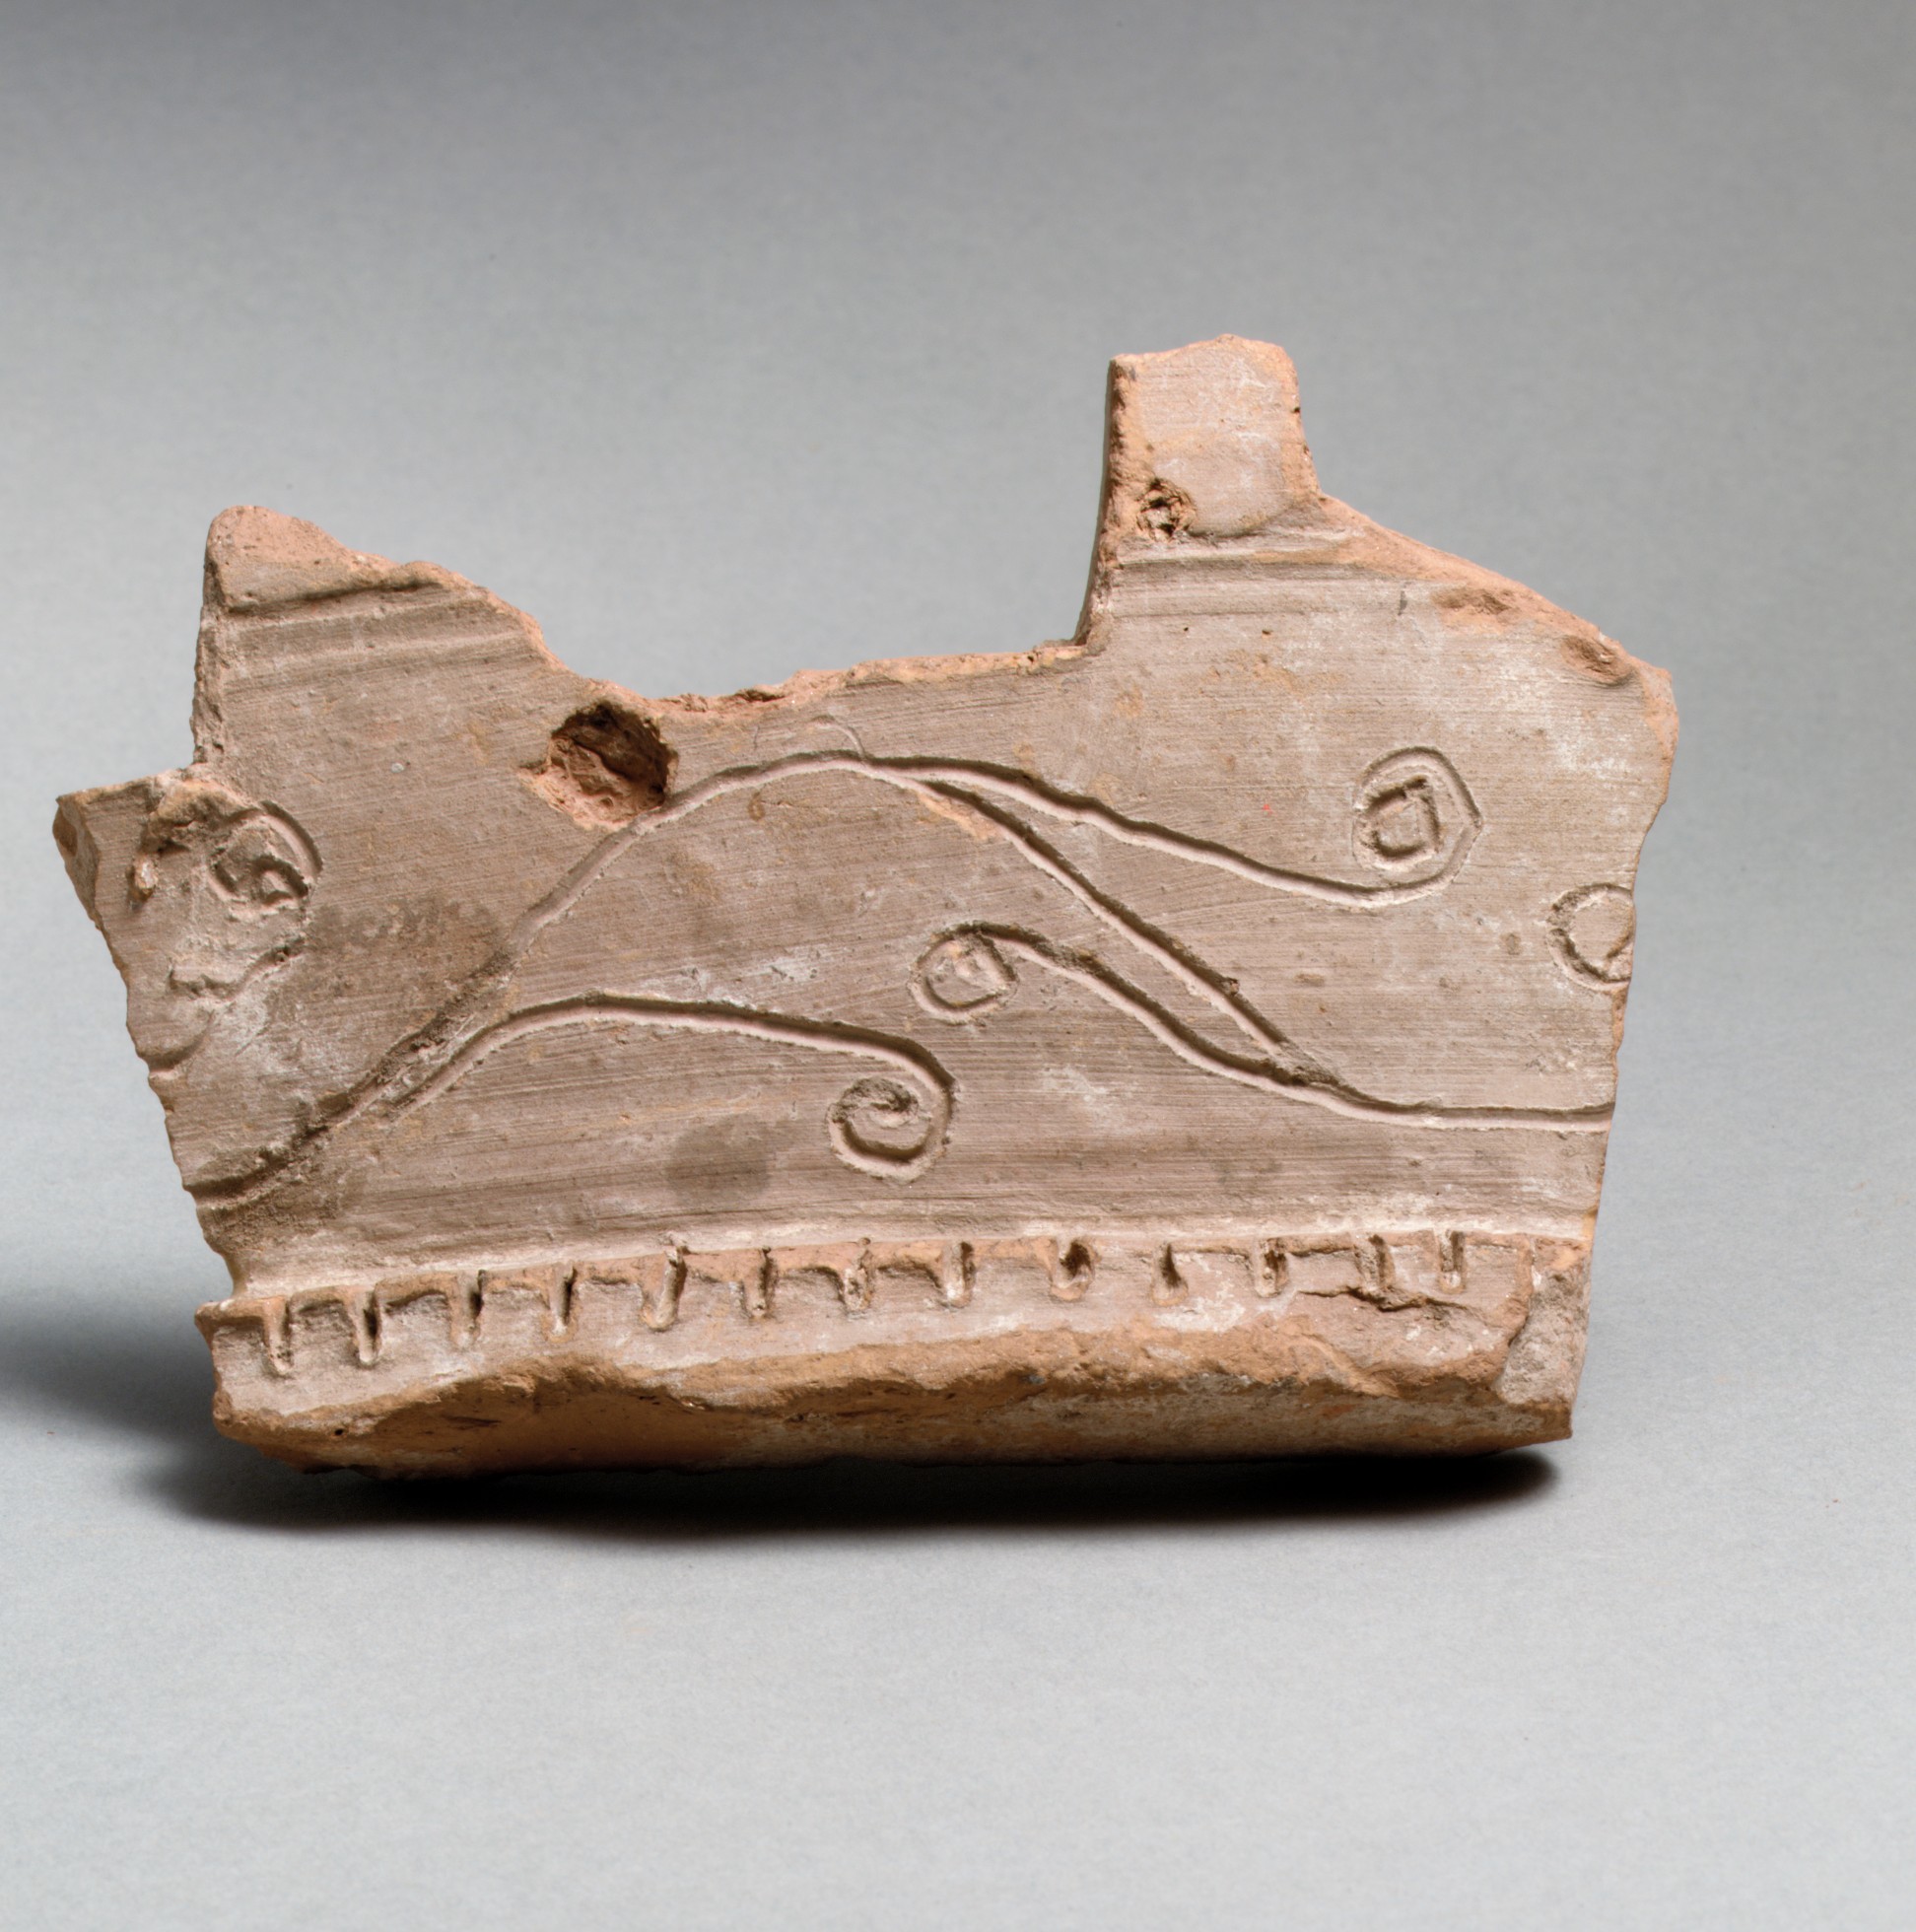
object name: vase fragment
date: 7000 BCE-330 CE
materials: terracotta